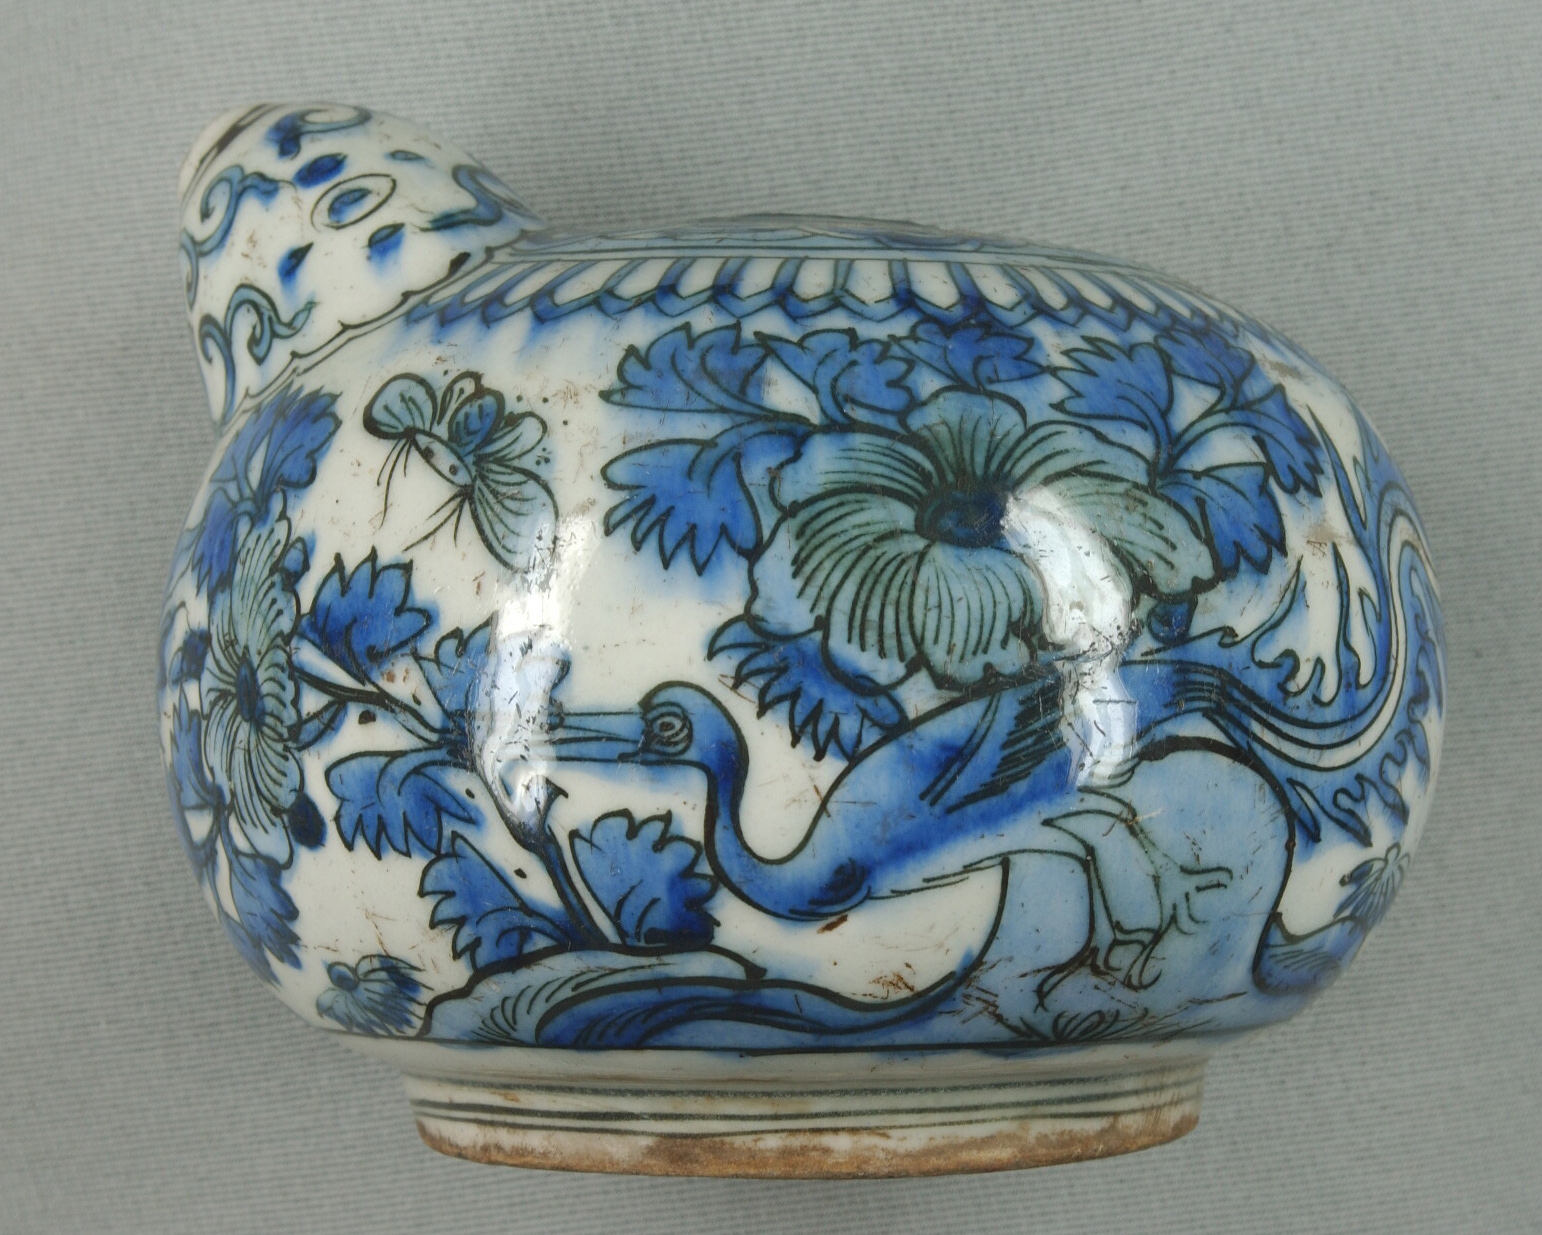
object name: kendi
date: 1601-1700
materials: glaze, stonepaste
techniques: painting, polychrome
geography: iran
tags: birds,flowers